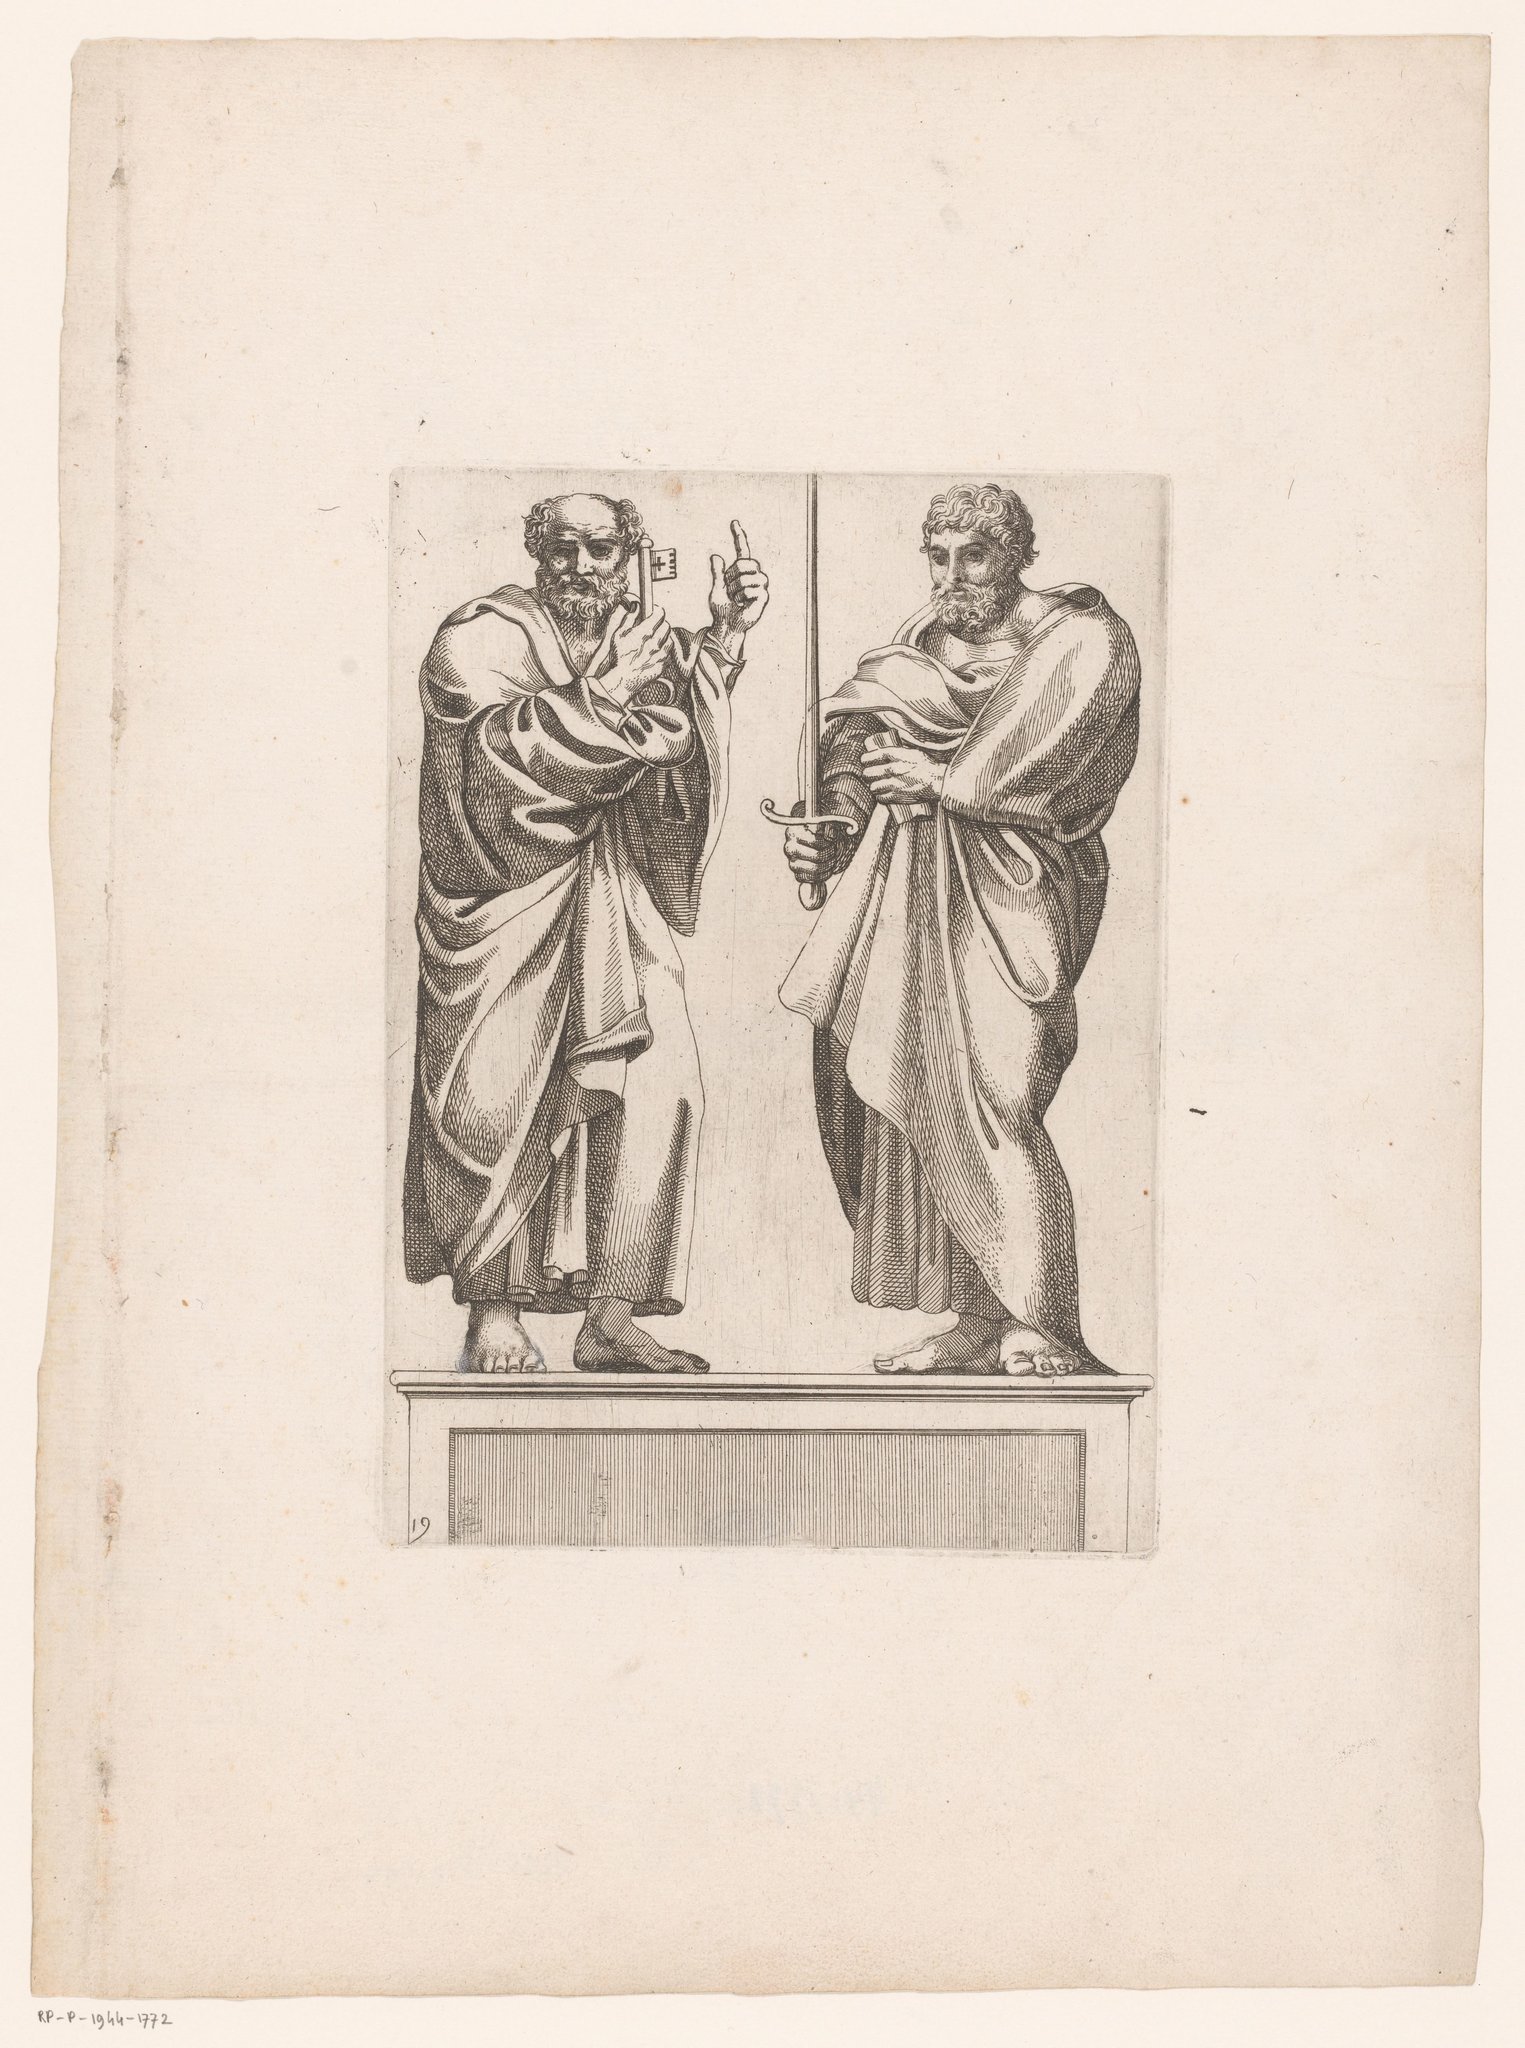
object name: print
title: Heilige Petrus en Heilige Paulus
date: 1646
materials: paper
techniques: etching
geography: rome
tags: the apostle peter, first bishop of rome; possible attributes: book, cock, (upturned) cross, (triple) crozier, fish, key, scroll, ship, tiara, the apostle paul of tarsus; possible attributes: book, scroll, sword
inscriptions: collector's mark: Lugt 2228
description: Maakt deel uit van een twintigdelige serie getiteld 'Vita di San Diego dipinta nella Capella di S. Giacomo de Spagnoli a Roma' met scènes uit het leven van Juan Diego Cuauhtlatoatzin door Annibale Carracci in Herrera kapel van de Nostra Signora del Sacro Cuore te Rome. De serie werd in 1646 uitgegeven in Rome.